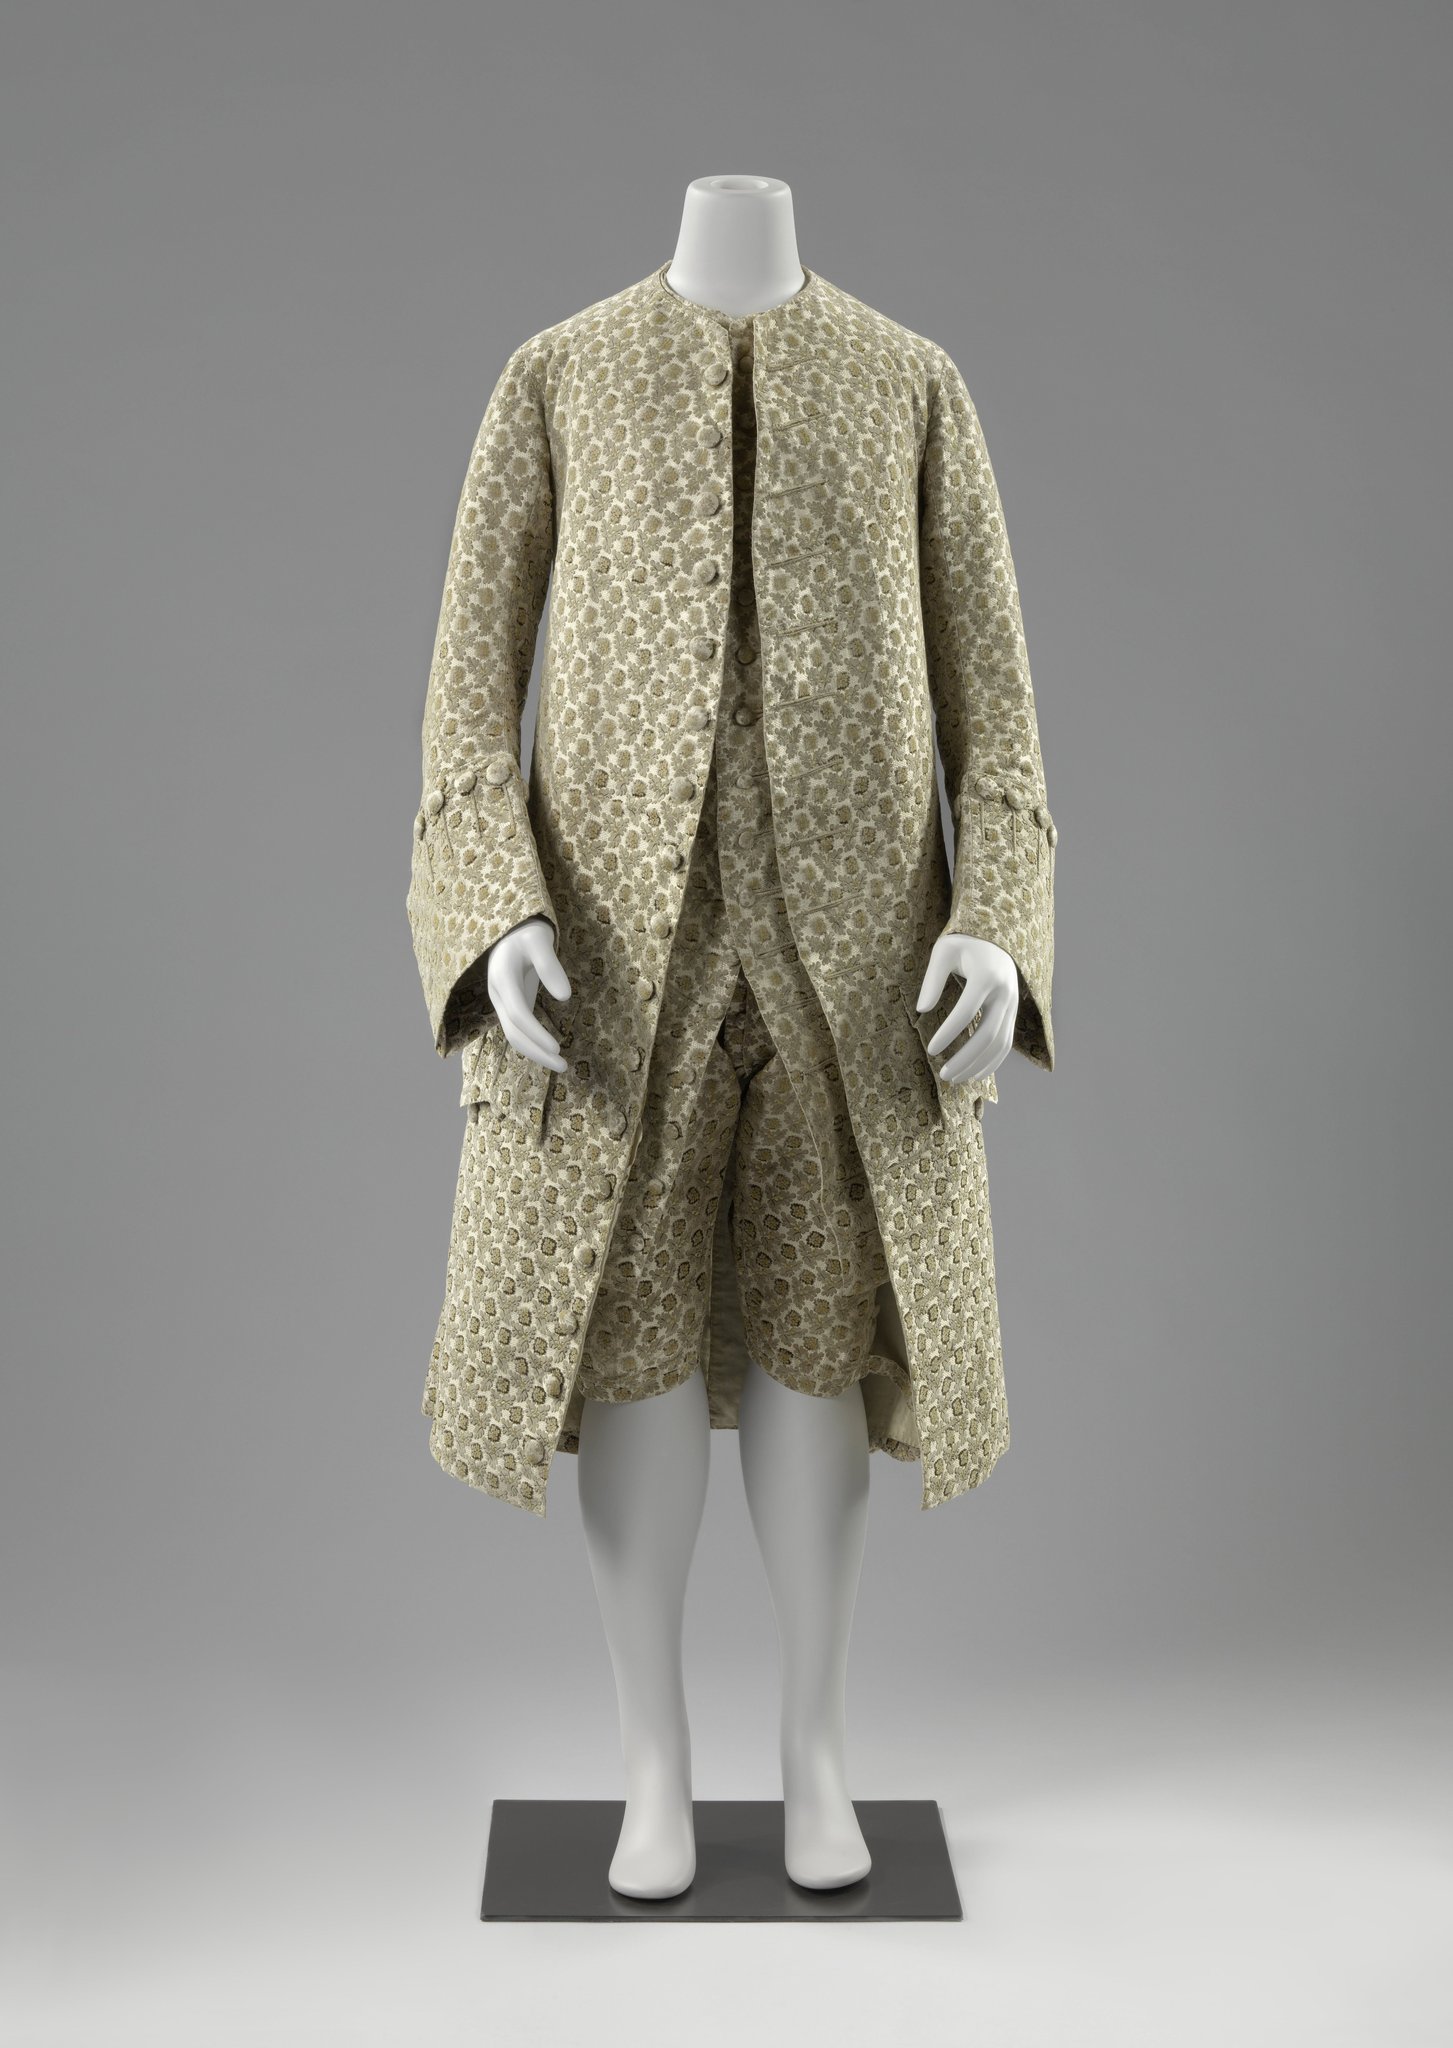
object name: menswear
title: Suit: coat, breaches and waistcoat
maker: Anonymous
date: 1740-1765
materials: textile, silk, wood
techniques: cutting, weave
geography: netherlands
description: The wide cuffs of this frock coat were in vogue in the early half of the 18th century. The faded fabric features a velvet floral pattern woven on a white ground. This material, with its small pattern, was designed for men. Often, as here, a whole suit would be made of the same fabric.